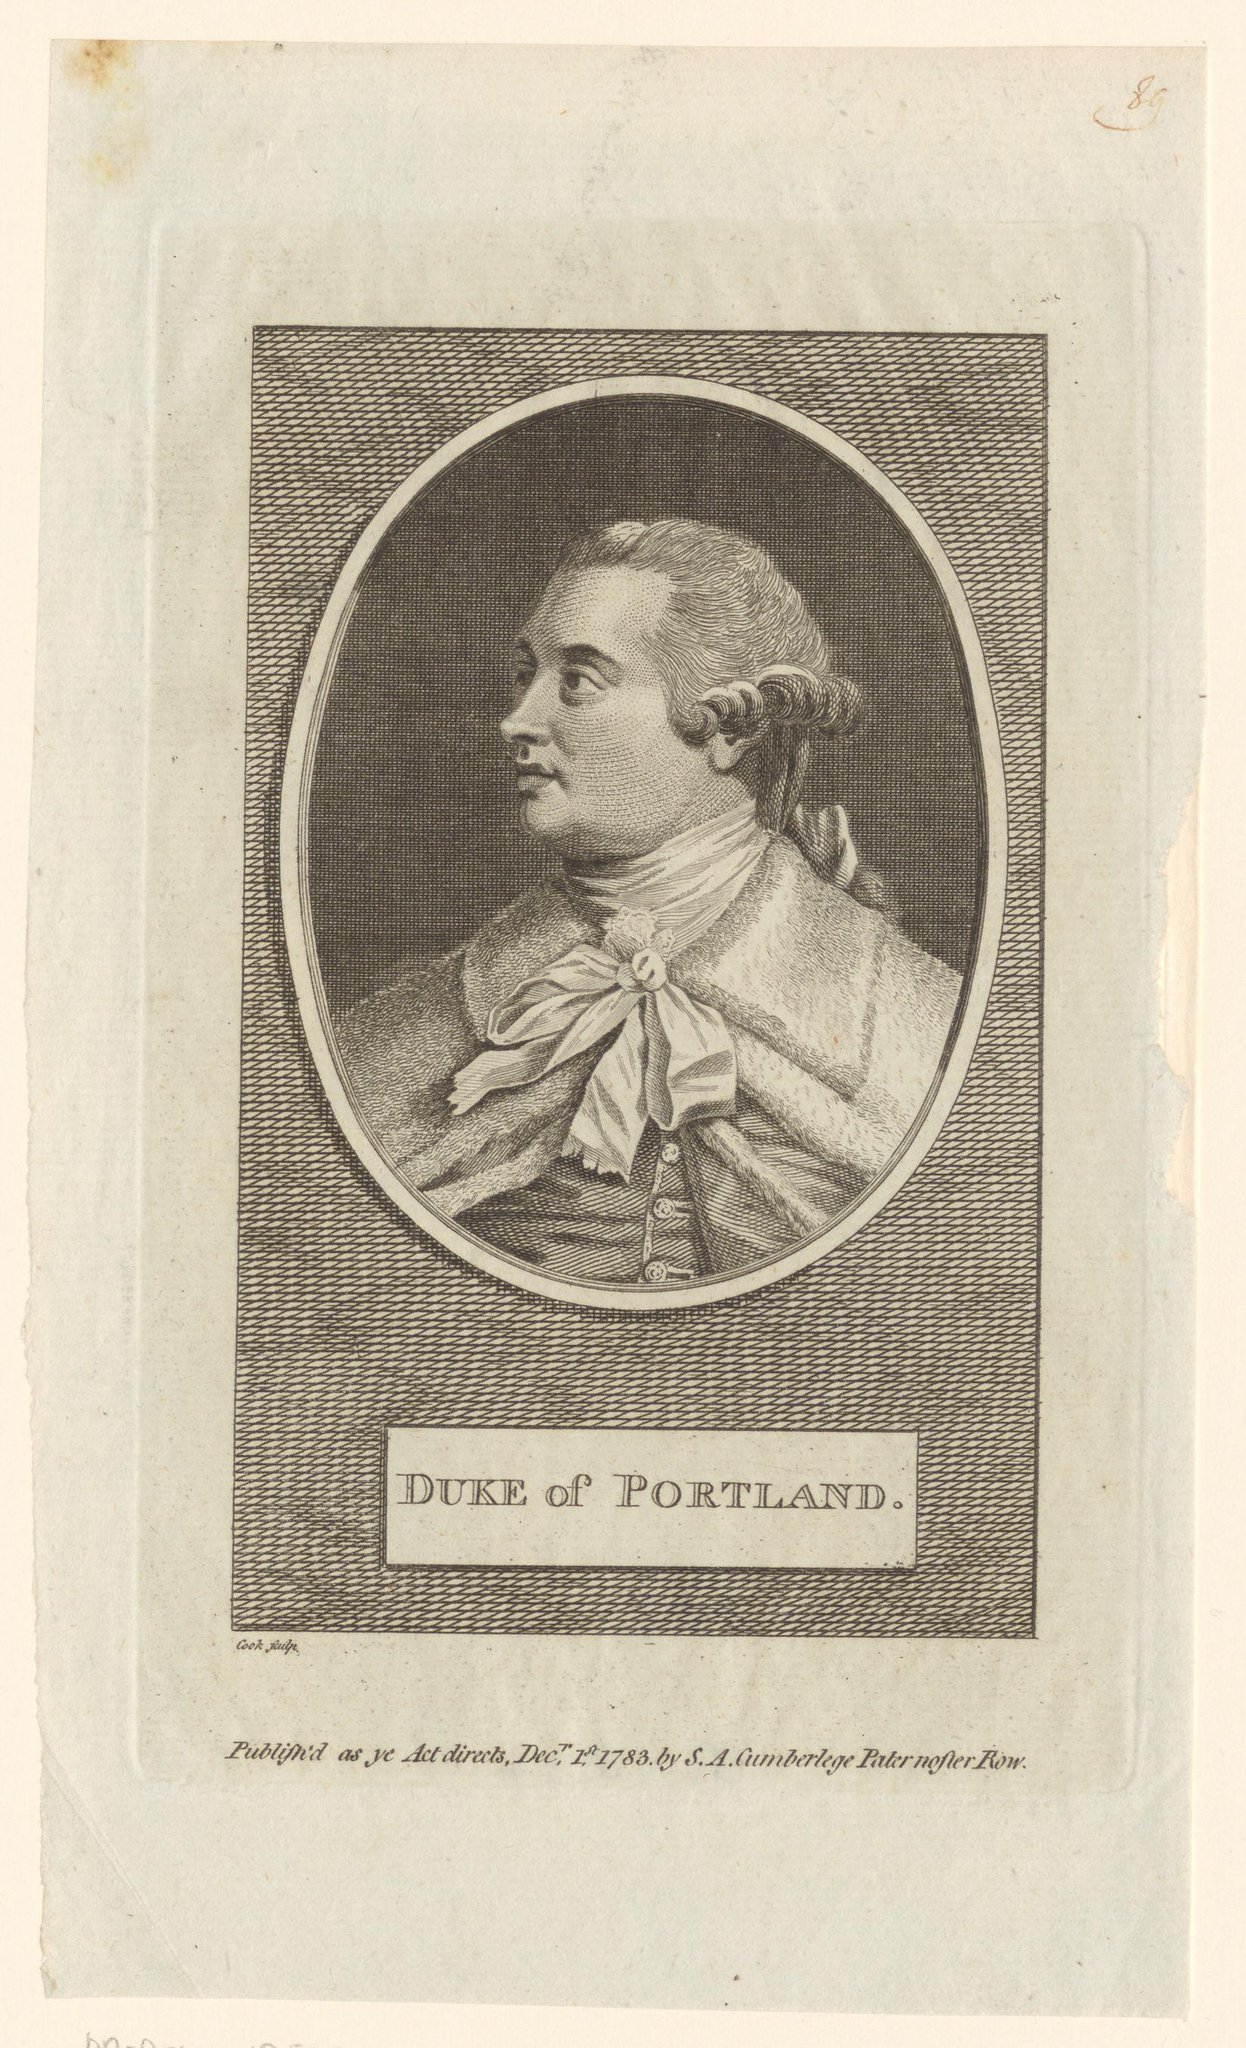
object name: print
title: Portret van William Henry Cavendish-Bentinck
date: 1783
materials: paper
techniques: engraving, etching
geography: london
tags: historical persons, politician, e.g. party leader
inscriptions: collector's mark: Lugt 2228, number: ‘89’